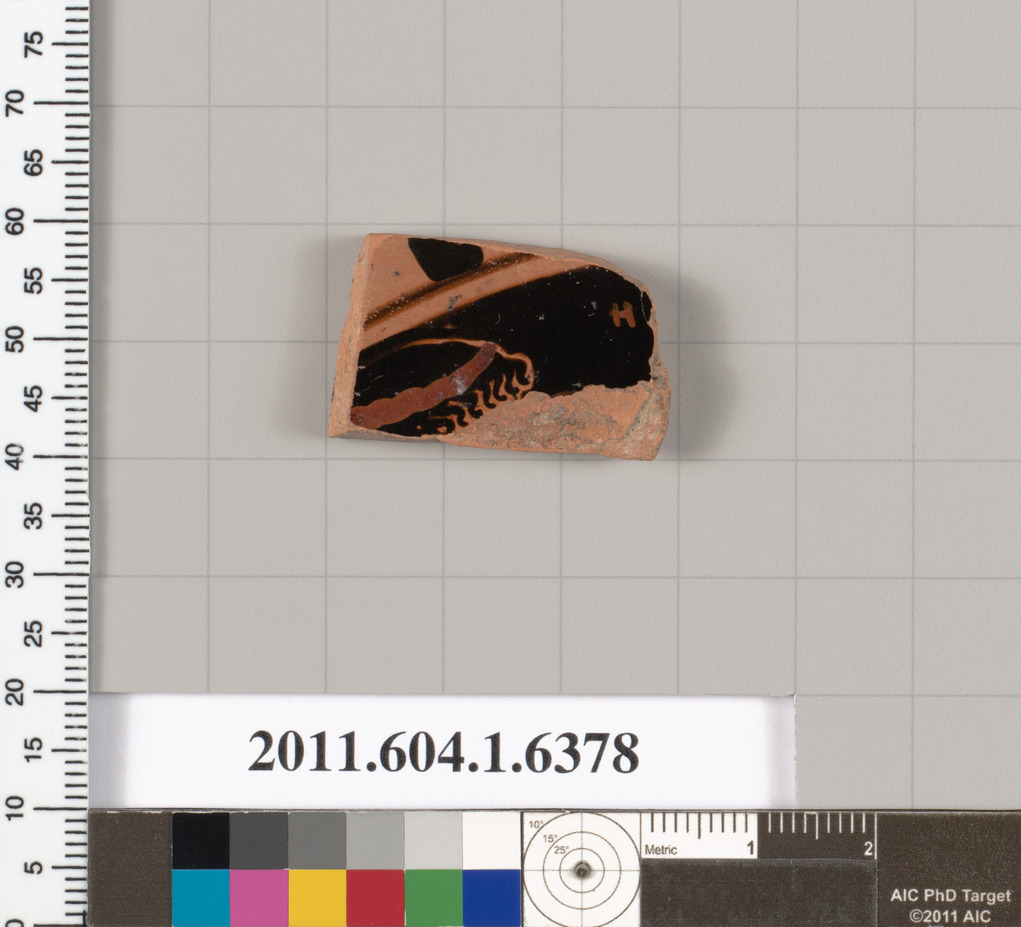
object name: kylix fragment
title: Terracotta fragment of a kylix (drinking cup)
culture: greek, attic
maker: antiphon painter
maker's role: artist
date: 490-480 BCE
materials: terracotta